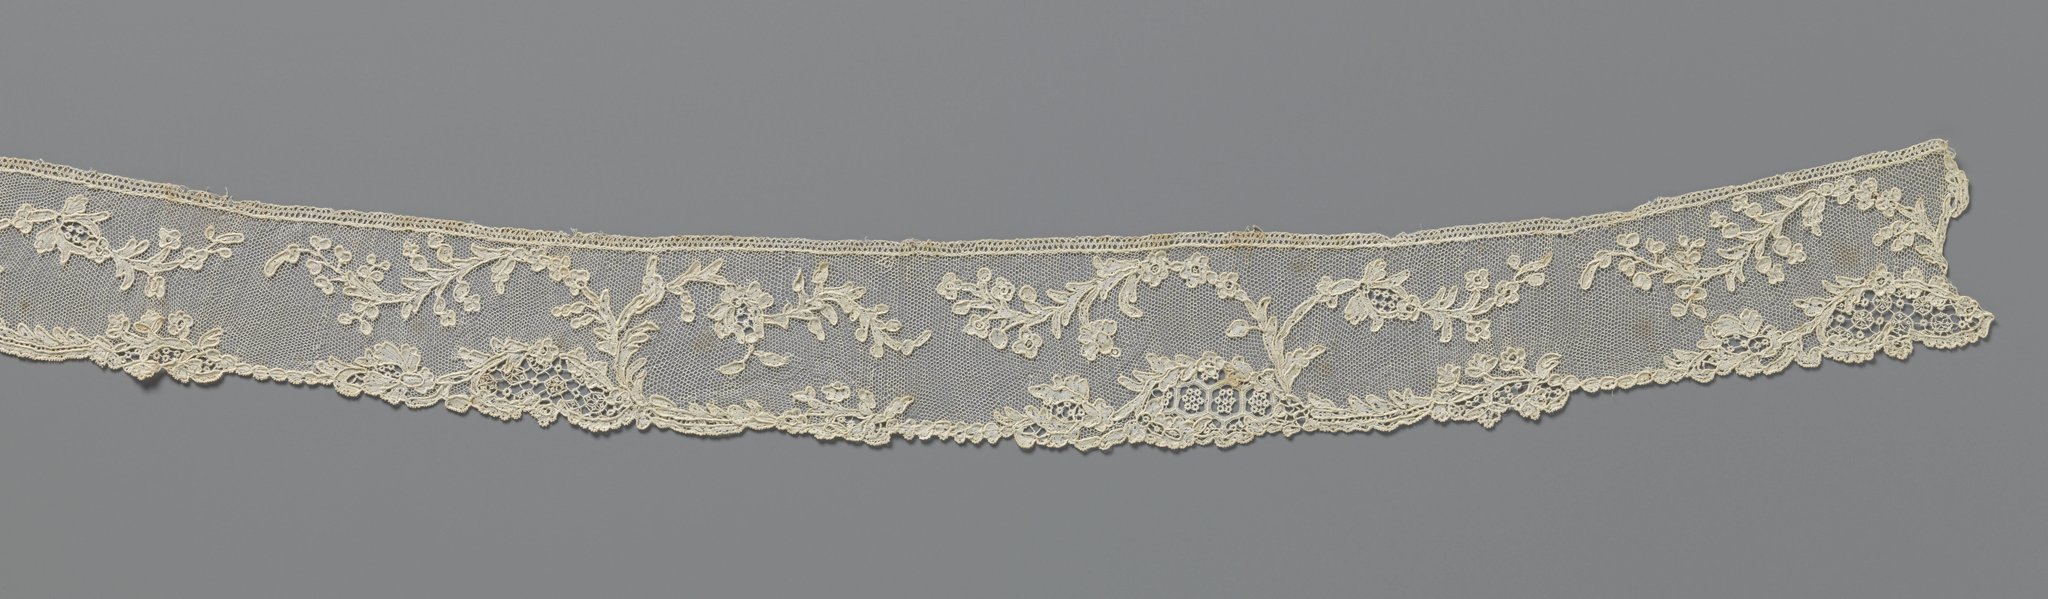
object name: strip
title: Strook naaldkant met hoog en breed uitlopende gespleten bloemtakken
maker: Anonymous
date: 1750-1775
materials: linen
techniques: lace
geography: alençon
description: Strook naturelkleurige naaldkant: Alençon-kant. Patroon met hoog en breed uitlopende gespleten bloemtakken op een fijne zeshoekige maasgrond. Eén van de drie takken vormt steeds een halve ovaal langs de onderrand, die gevuld is met afwisselende siergronden. De onderzijde is afgewerkt met een gepicoteerde schulpenrand, die voortkomt uit een patroon van liggende bladeren en bloemen en enkele kleine met siergronden opgevulde ruimtes. De bovenzijde is afgewerkt met een rand kloskant.